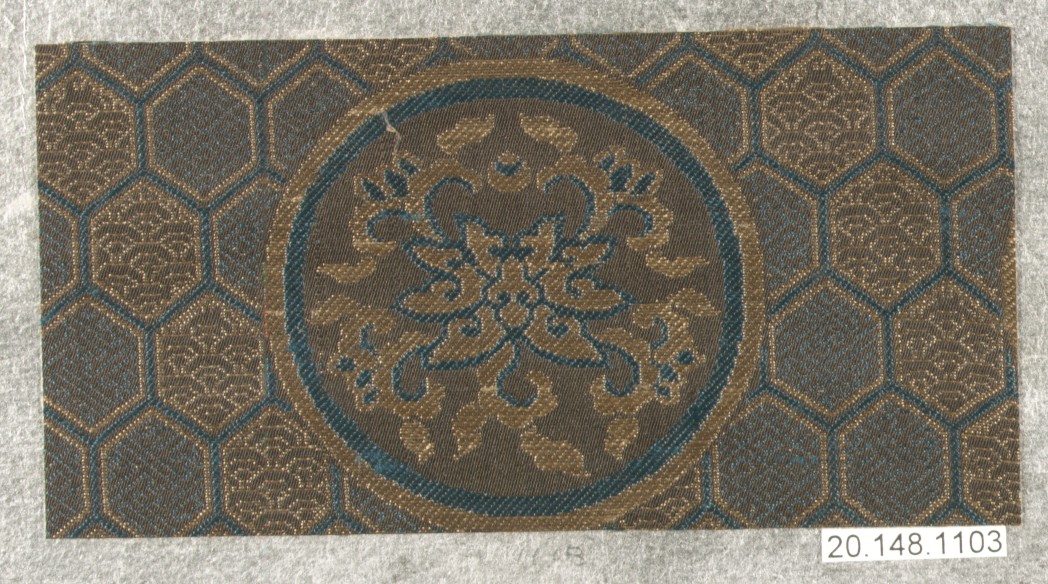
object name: piece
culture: japanese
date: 1701-1800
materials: silk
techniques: compound weave